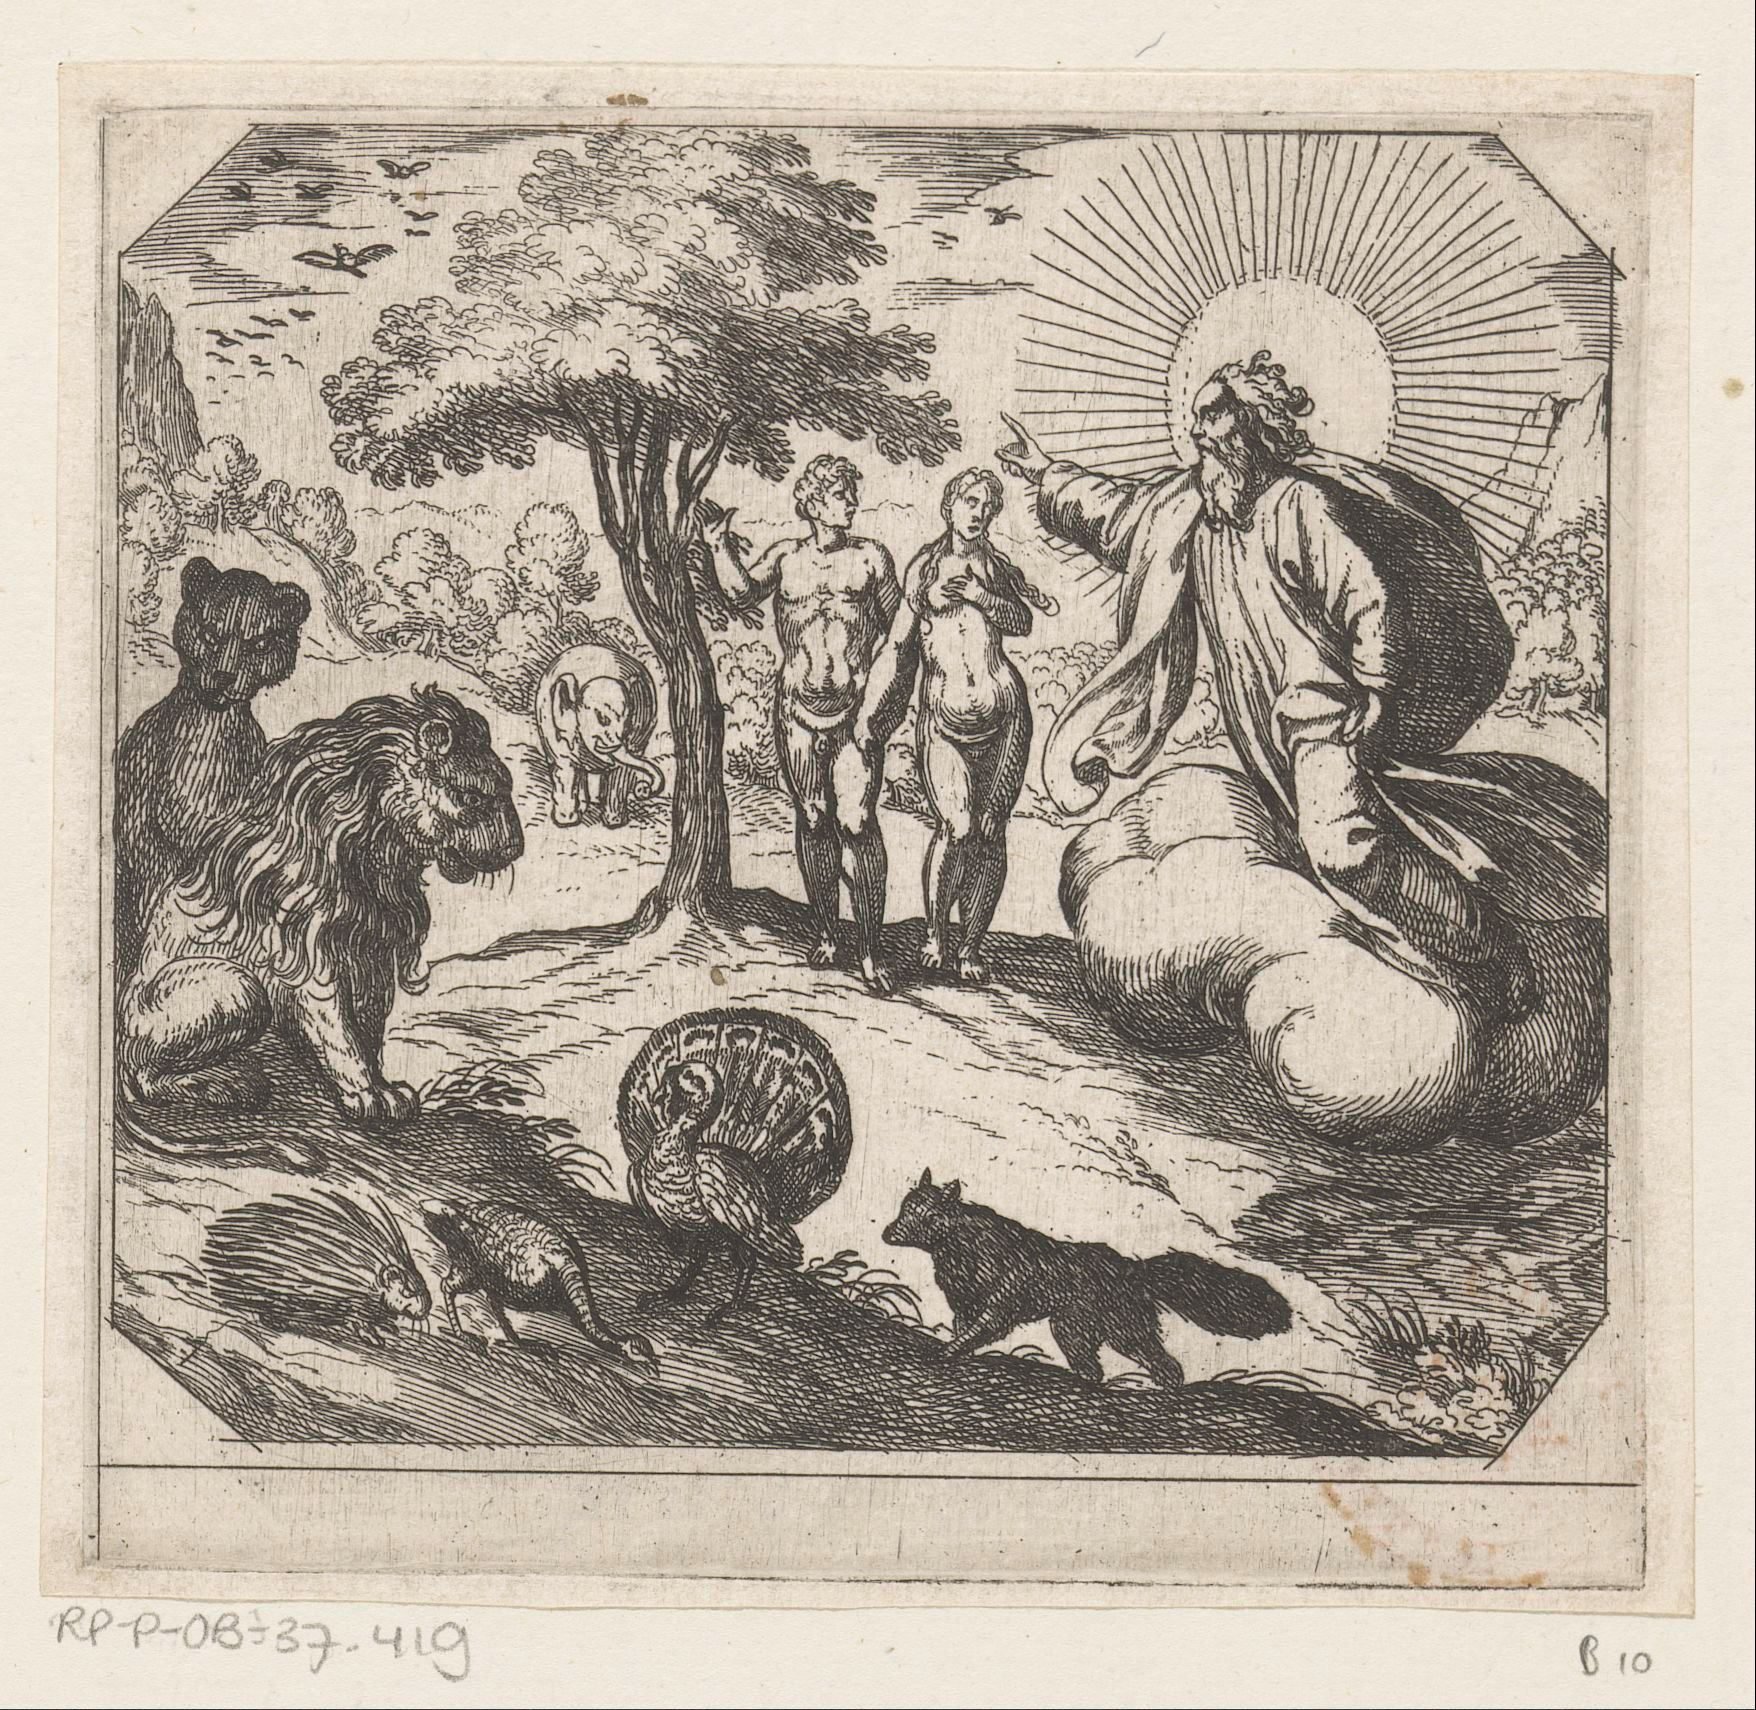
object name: print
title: God verbiedt Adam en Eva van de boom der kennis te eten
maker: antonio tempesta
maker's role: draughtsman, painter, print maker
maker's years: 1555-1630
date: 1565-1630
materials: paper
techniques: etching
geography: rome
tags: the giving of the test commandment: god warns adam and eve not to eat from the tree of knowledge of good and evil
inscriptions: collector's mark: Lugt 240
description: Deze prent maakt deel uit van een serie van twaalf prenten van de schepping. De prenten zijn deels naar ontwerpen van Rafaël voor de Loggia van Rafaël in het Vaticaan, en deels naar prenten door Nicolaes de Bruyn naar ontwerpen van Maerten de Vos (zie: Holl. Dutch. vol. 45 nr. 1-10).